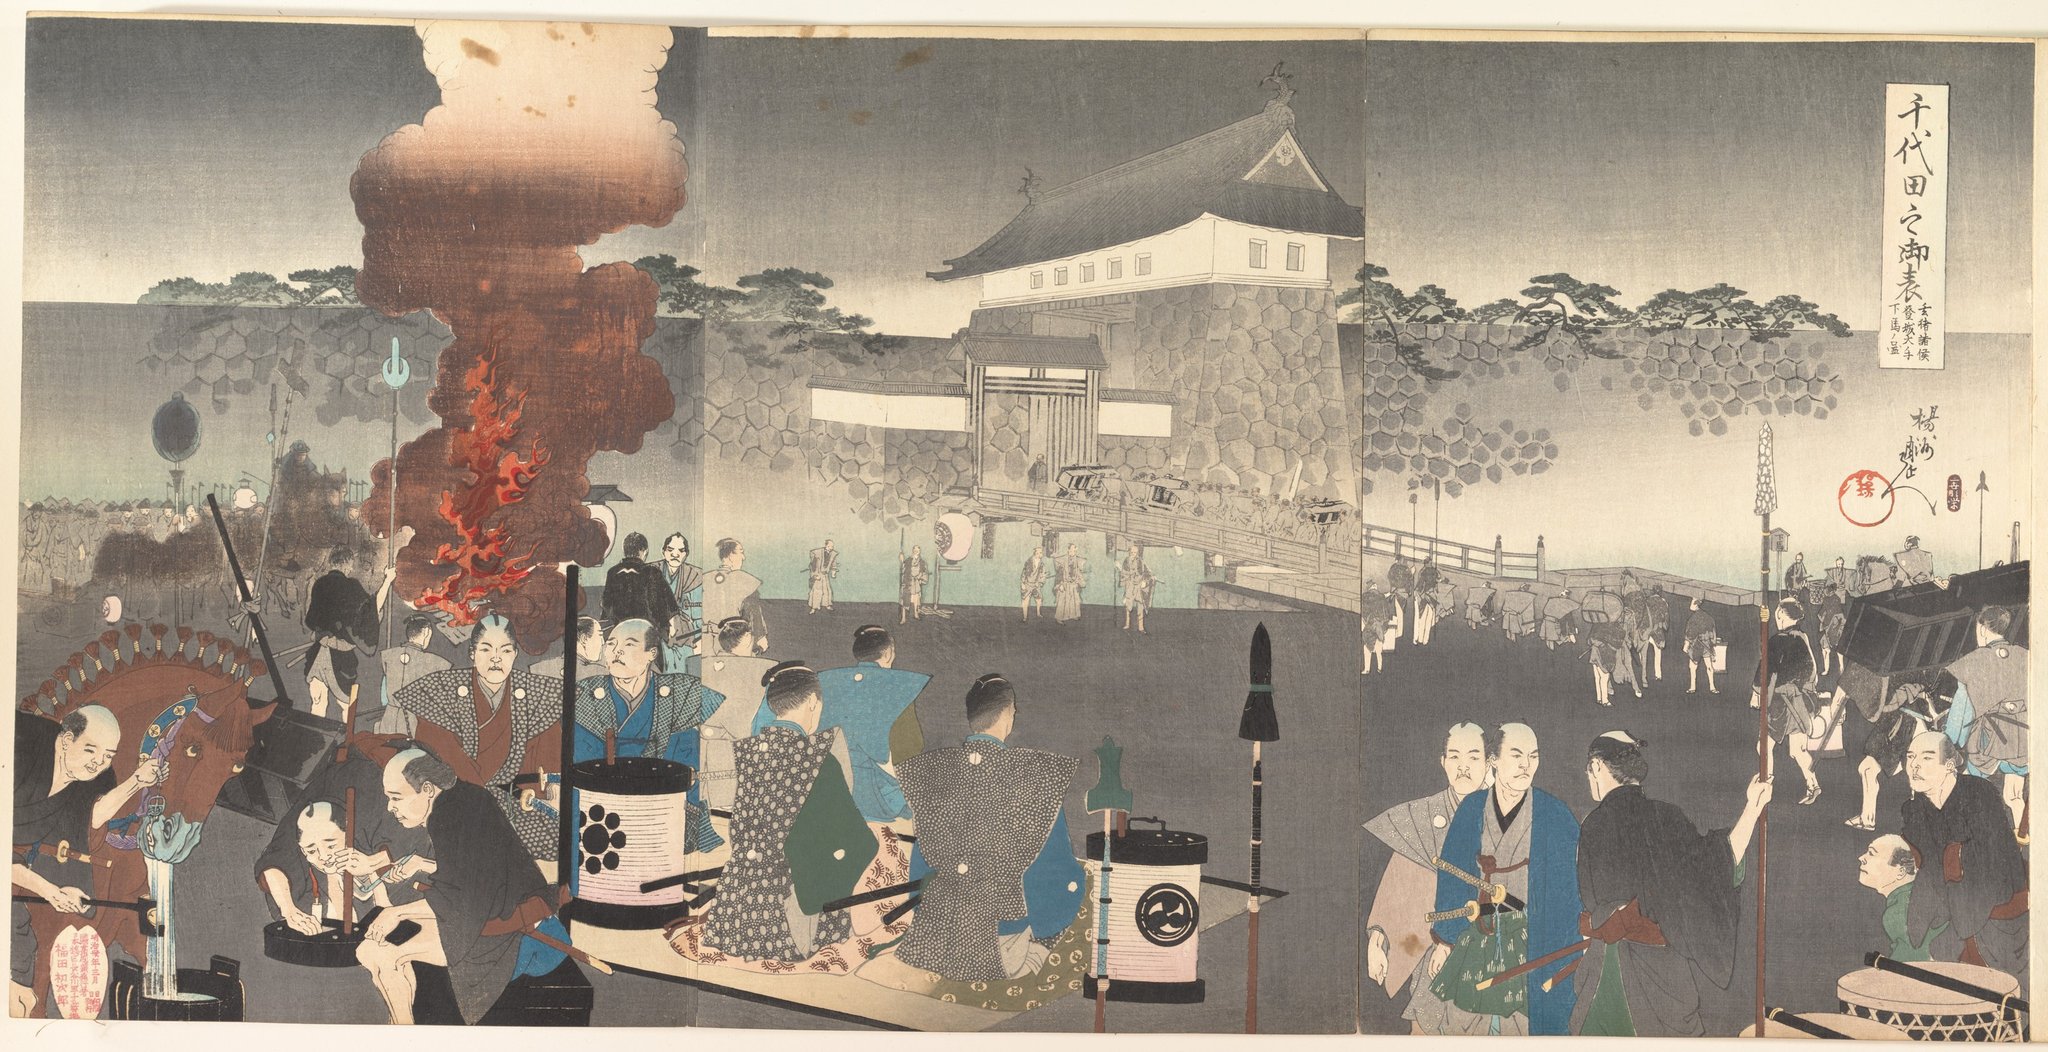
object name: print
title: Chiyoda Castle (Album of Men)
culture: japanese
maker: yōshū (hashimoto) chikanobu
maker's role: artist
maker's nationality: japanese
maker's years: 1838-1912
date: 1897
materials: ink, paper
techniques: woodblock print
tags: castles,bridges,horses,fire,crowd